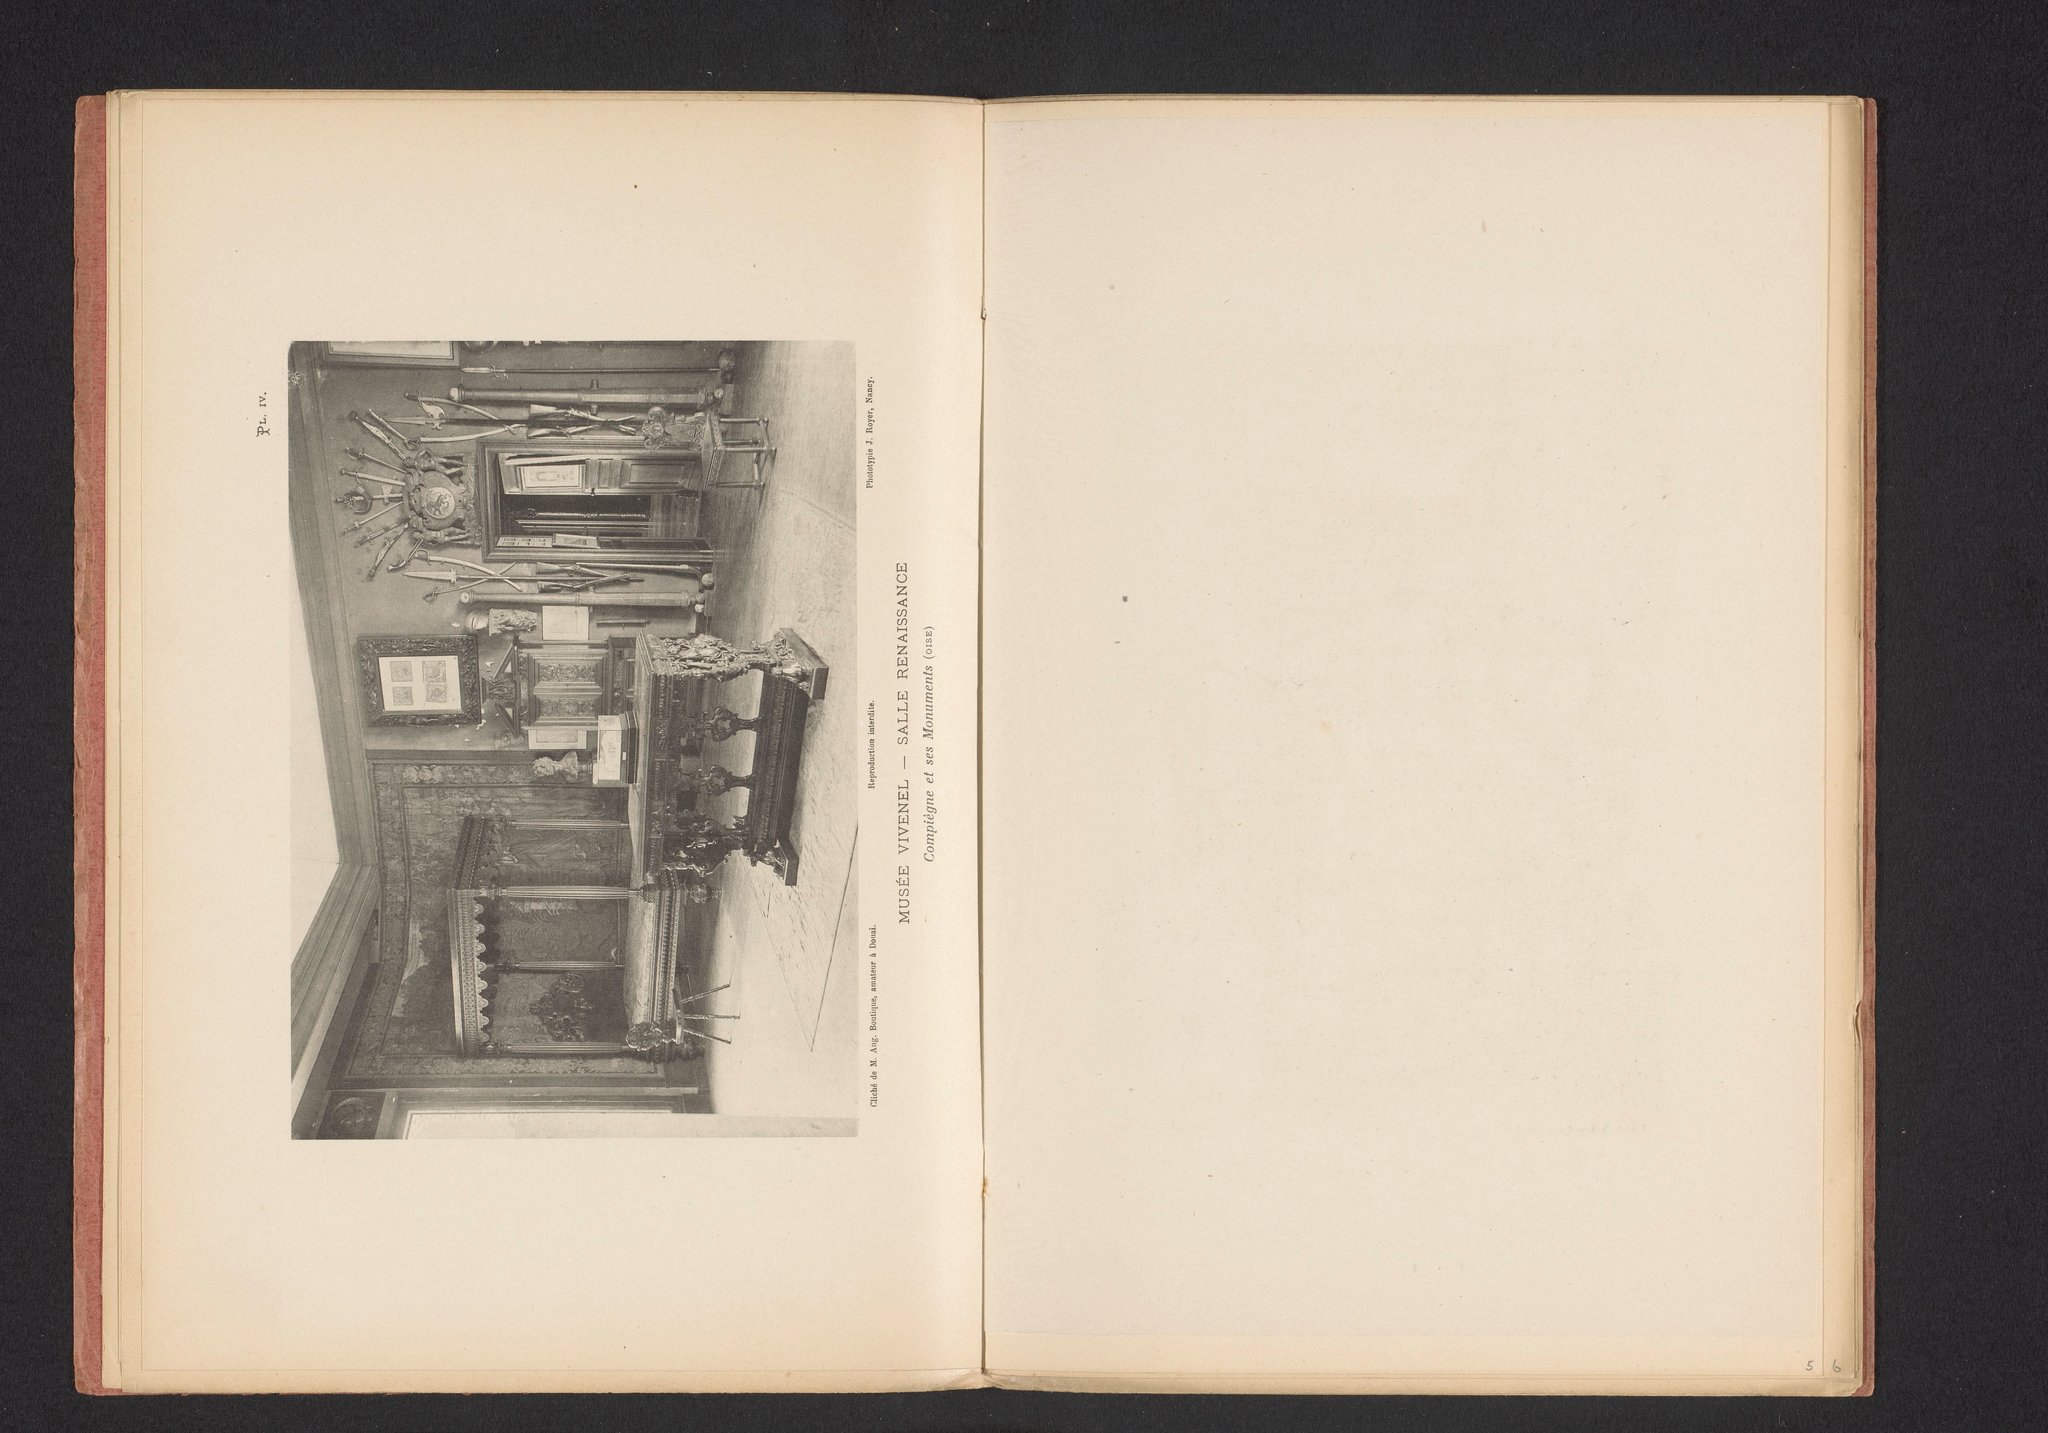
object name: page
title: Musée Vivenel - Salle Renaissance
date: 1890-1895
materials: paper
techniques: photograph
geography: douai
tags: permanent exhibition, museum, furniture and household effects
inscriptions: inscription: ‘Reproduction interdite.’, number: ‘Pl. IV.’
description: Prent op tweede ongenummerde pagina na pagina 4.